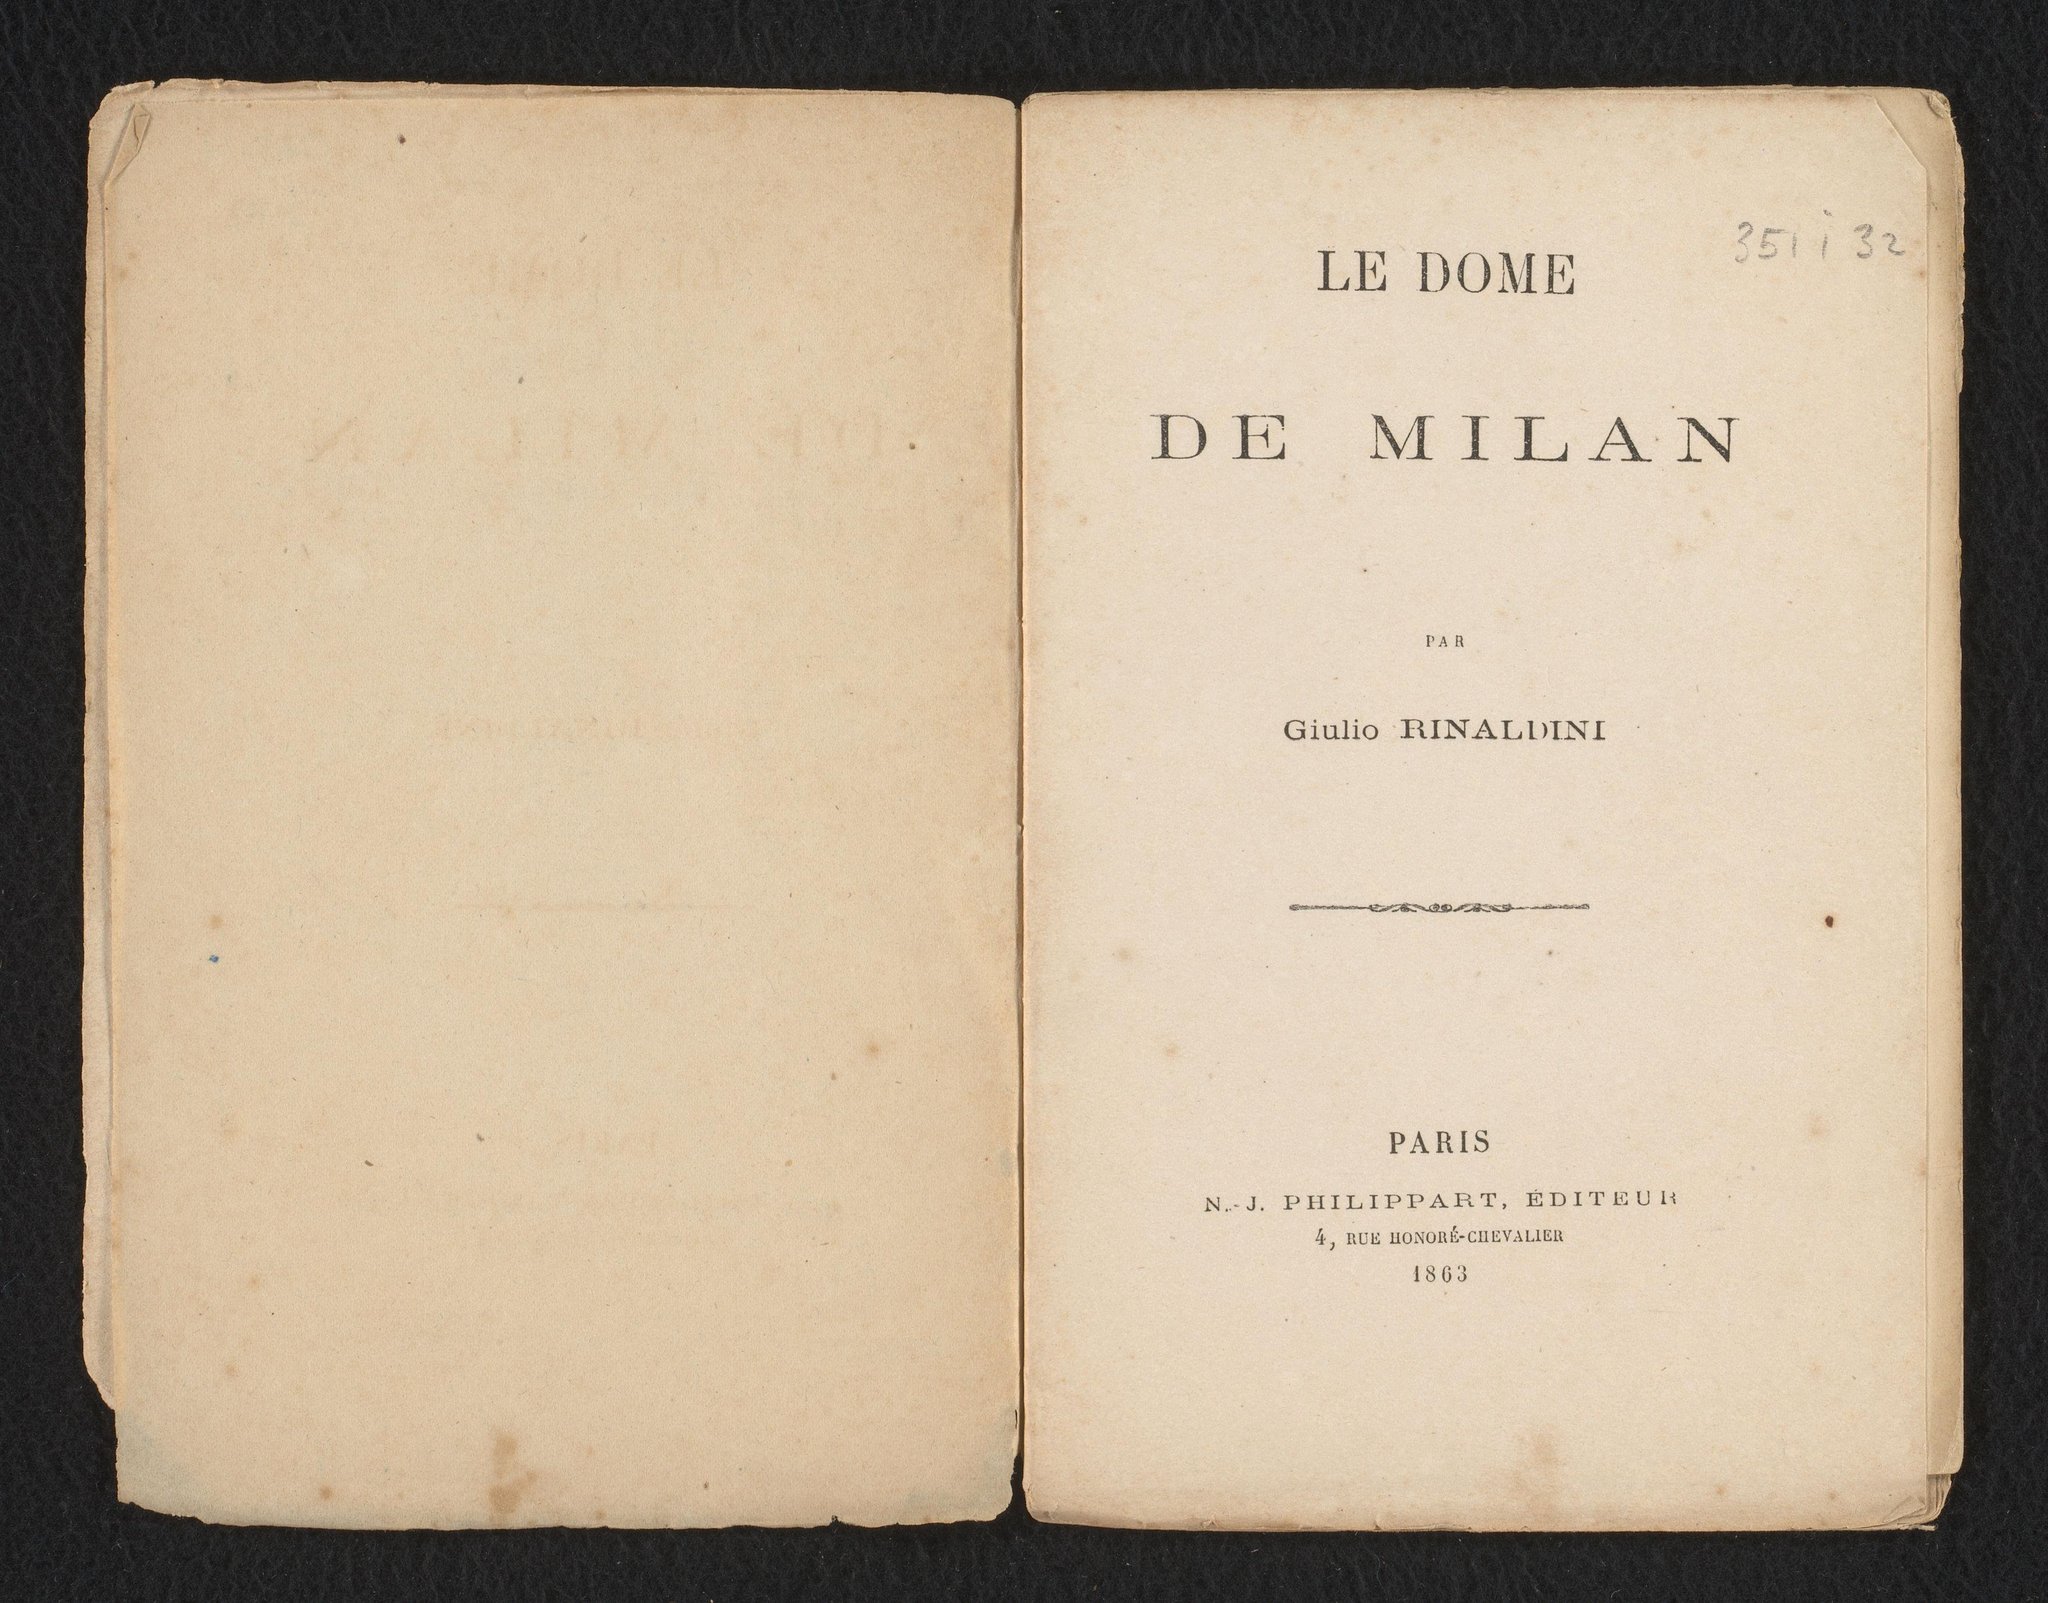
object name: book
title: La cathédrale de Milan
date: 1863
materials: paper, cardboard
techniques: albumen print, letterpress printing, lithograph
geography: paris